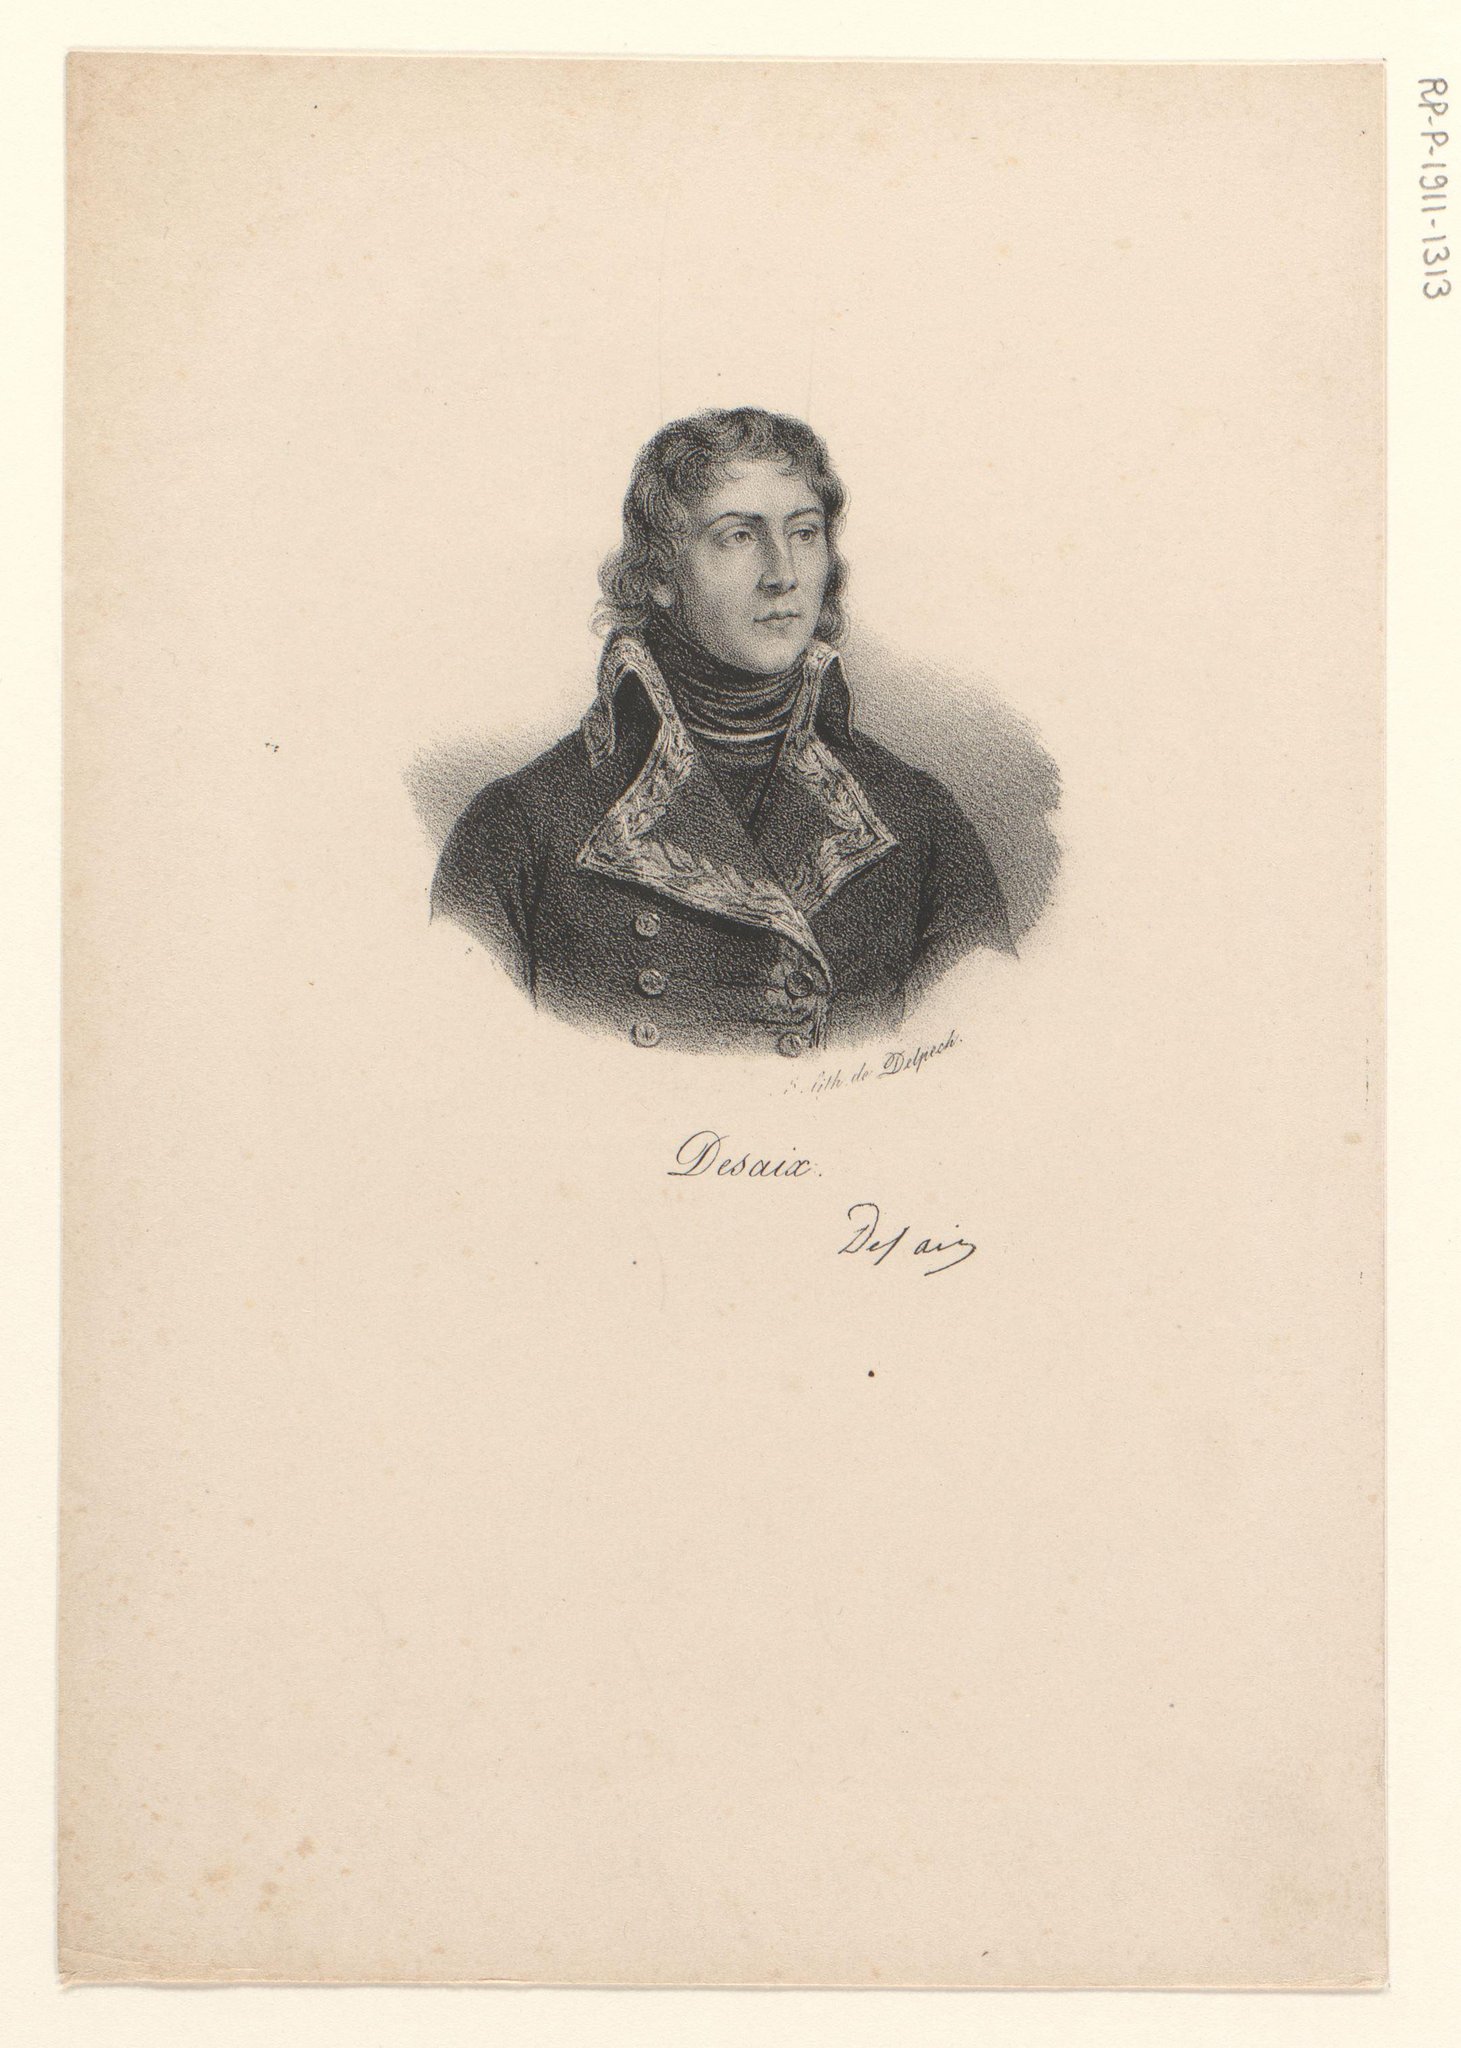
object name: print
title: Portret van Louis-Charles-Antoine Desaix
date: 1818-1842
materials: paper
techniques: lithograph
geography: paris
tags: historical persons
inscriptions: collector's mark: Lugt 2228a